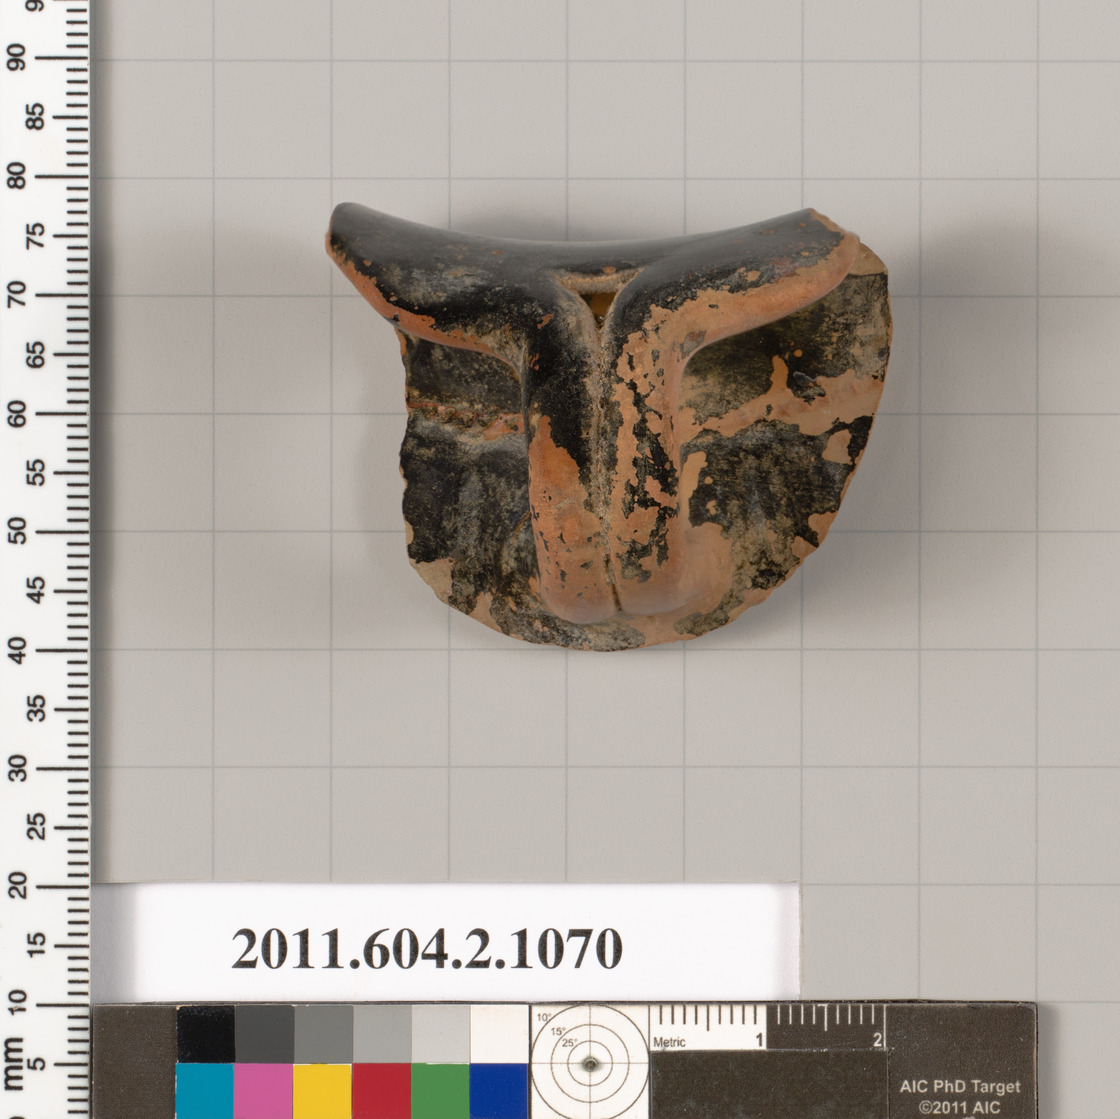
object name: mug, oinochoe, shape 8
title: Terracotta fragments of a mug, oinochoe, shape 8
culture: greek, attic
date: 500-401 BCE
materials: terracotta